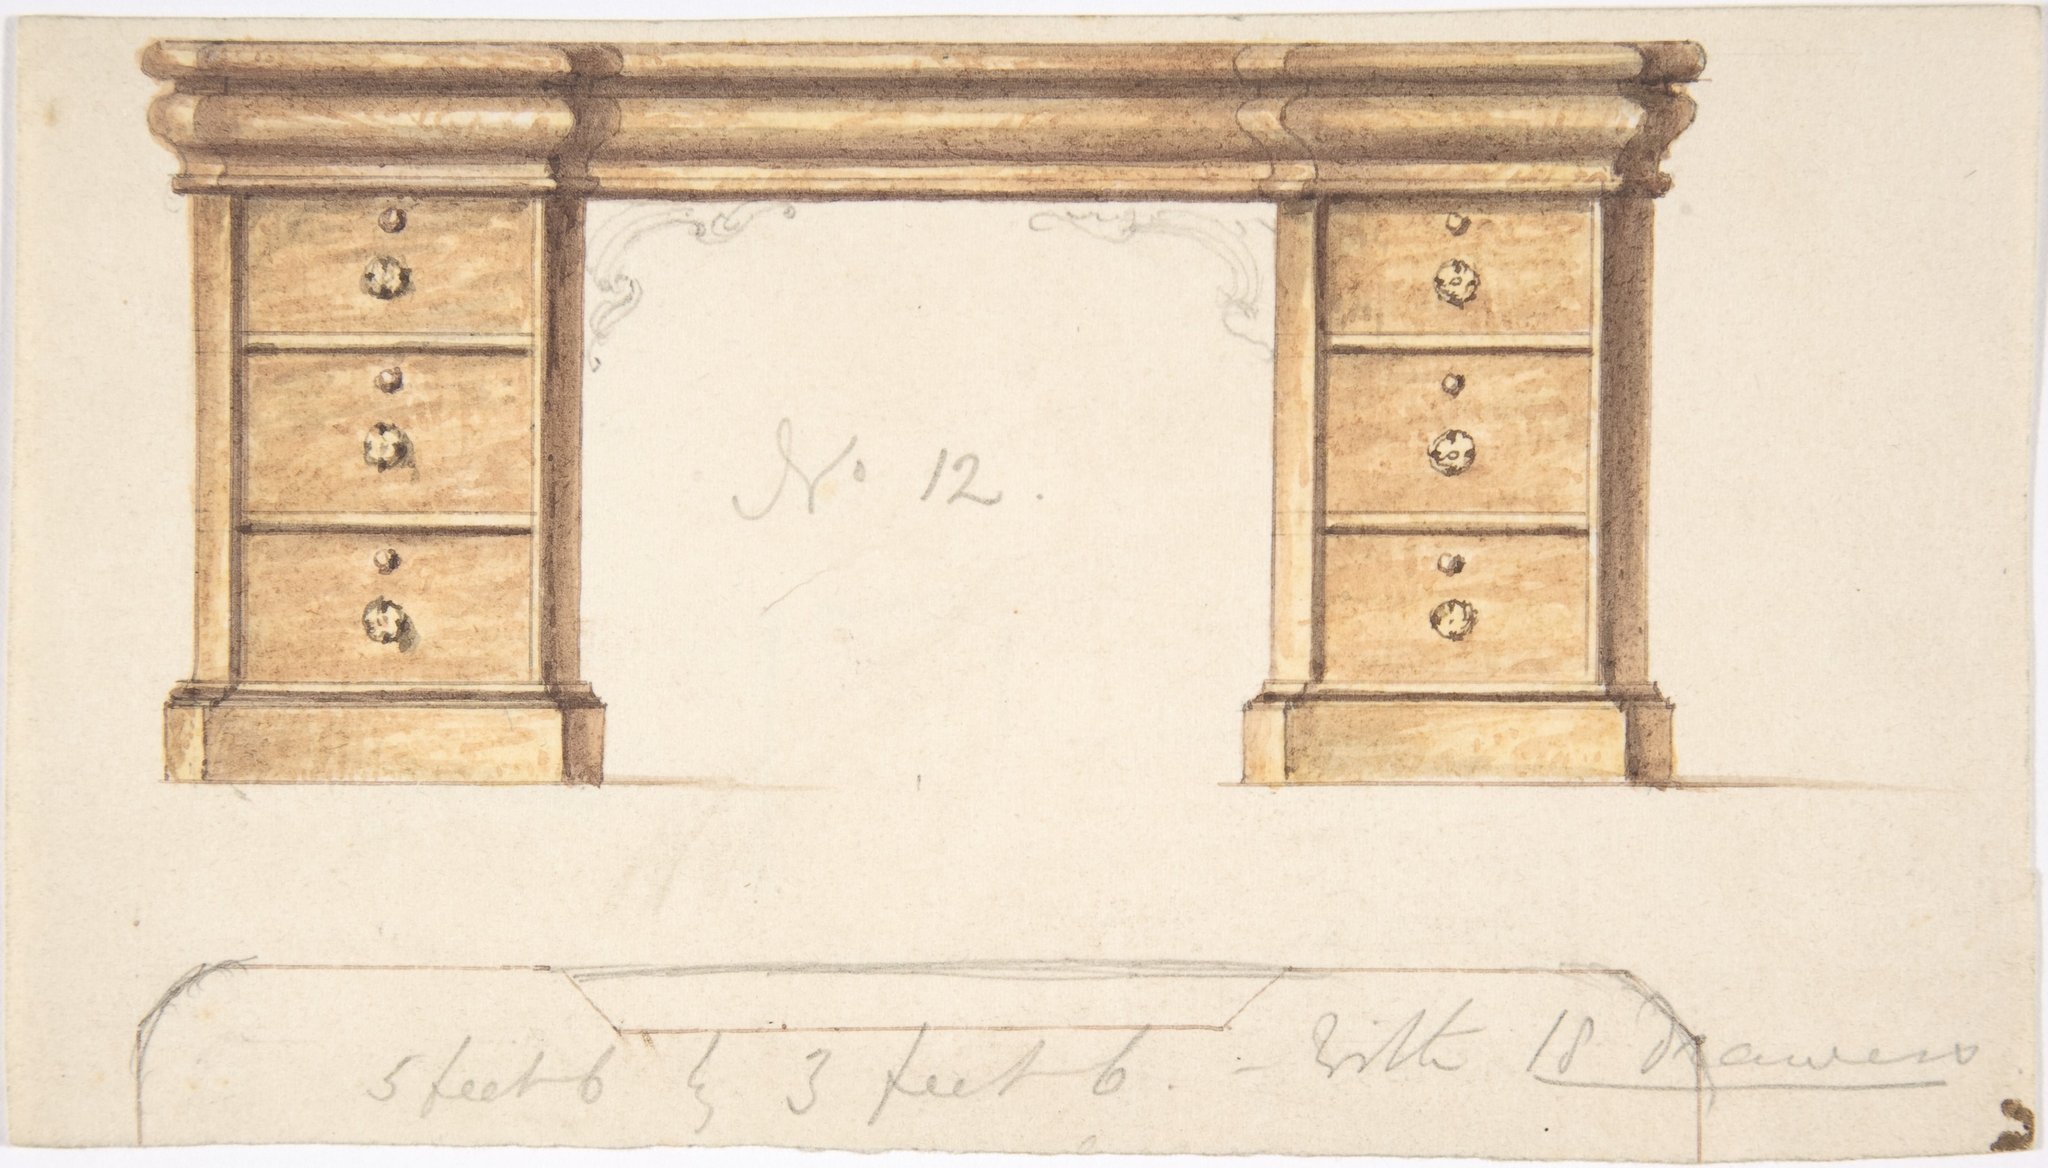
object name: drawing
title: Design for a Desk with Two Sets of Drawers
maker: anonymous, british, 19th century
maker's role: artist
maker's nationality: british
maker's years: 1800-1900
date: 1801-1833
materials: ink, watercolor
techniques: pen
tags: desks